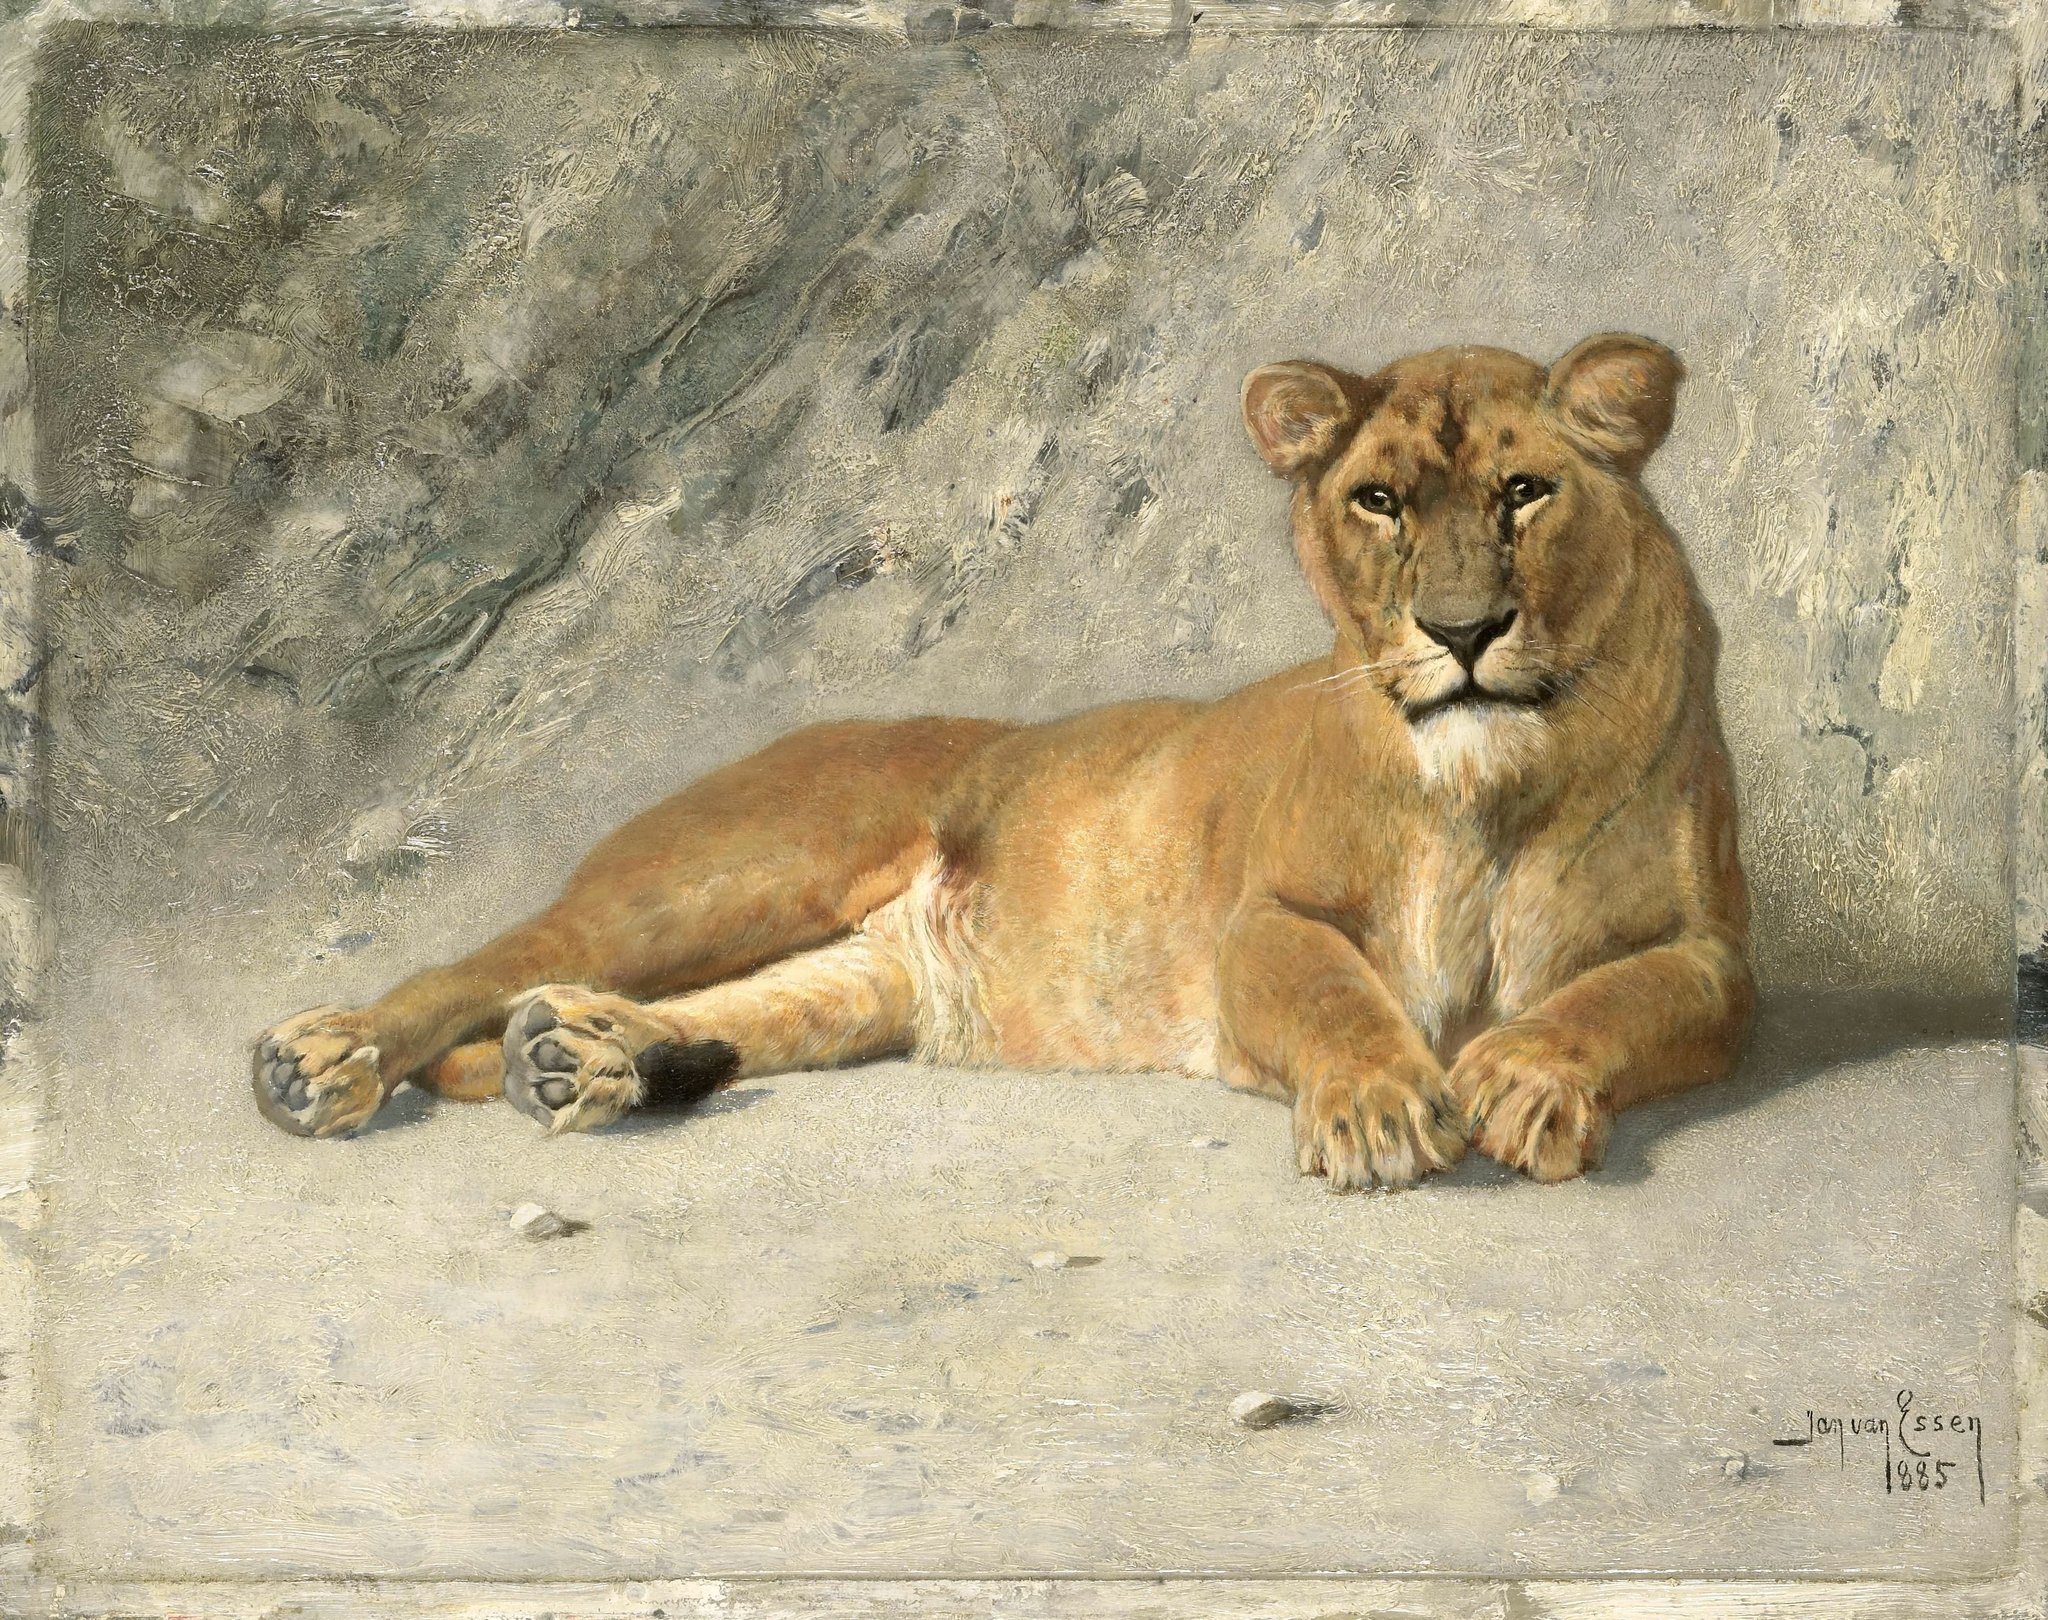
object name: painting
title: Lioness Resting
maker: jan van essen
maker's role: draughtsman, print maker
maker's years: 1854-1936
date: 1885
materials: oil, panel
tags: beasts of prey, predatory animals: lion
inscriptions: signature and date: ‘Jan van Essen 1885’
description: Een liggende leeuwin, voor een steil oplopende achtergrond.